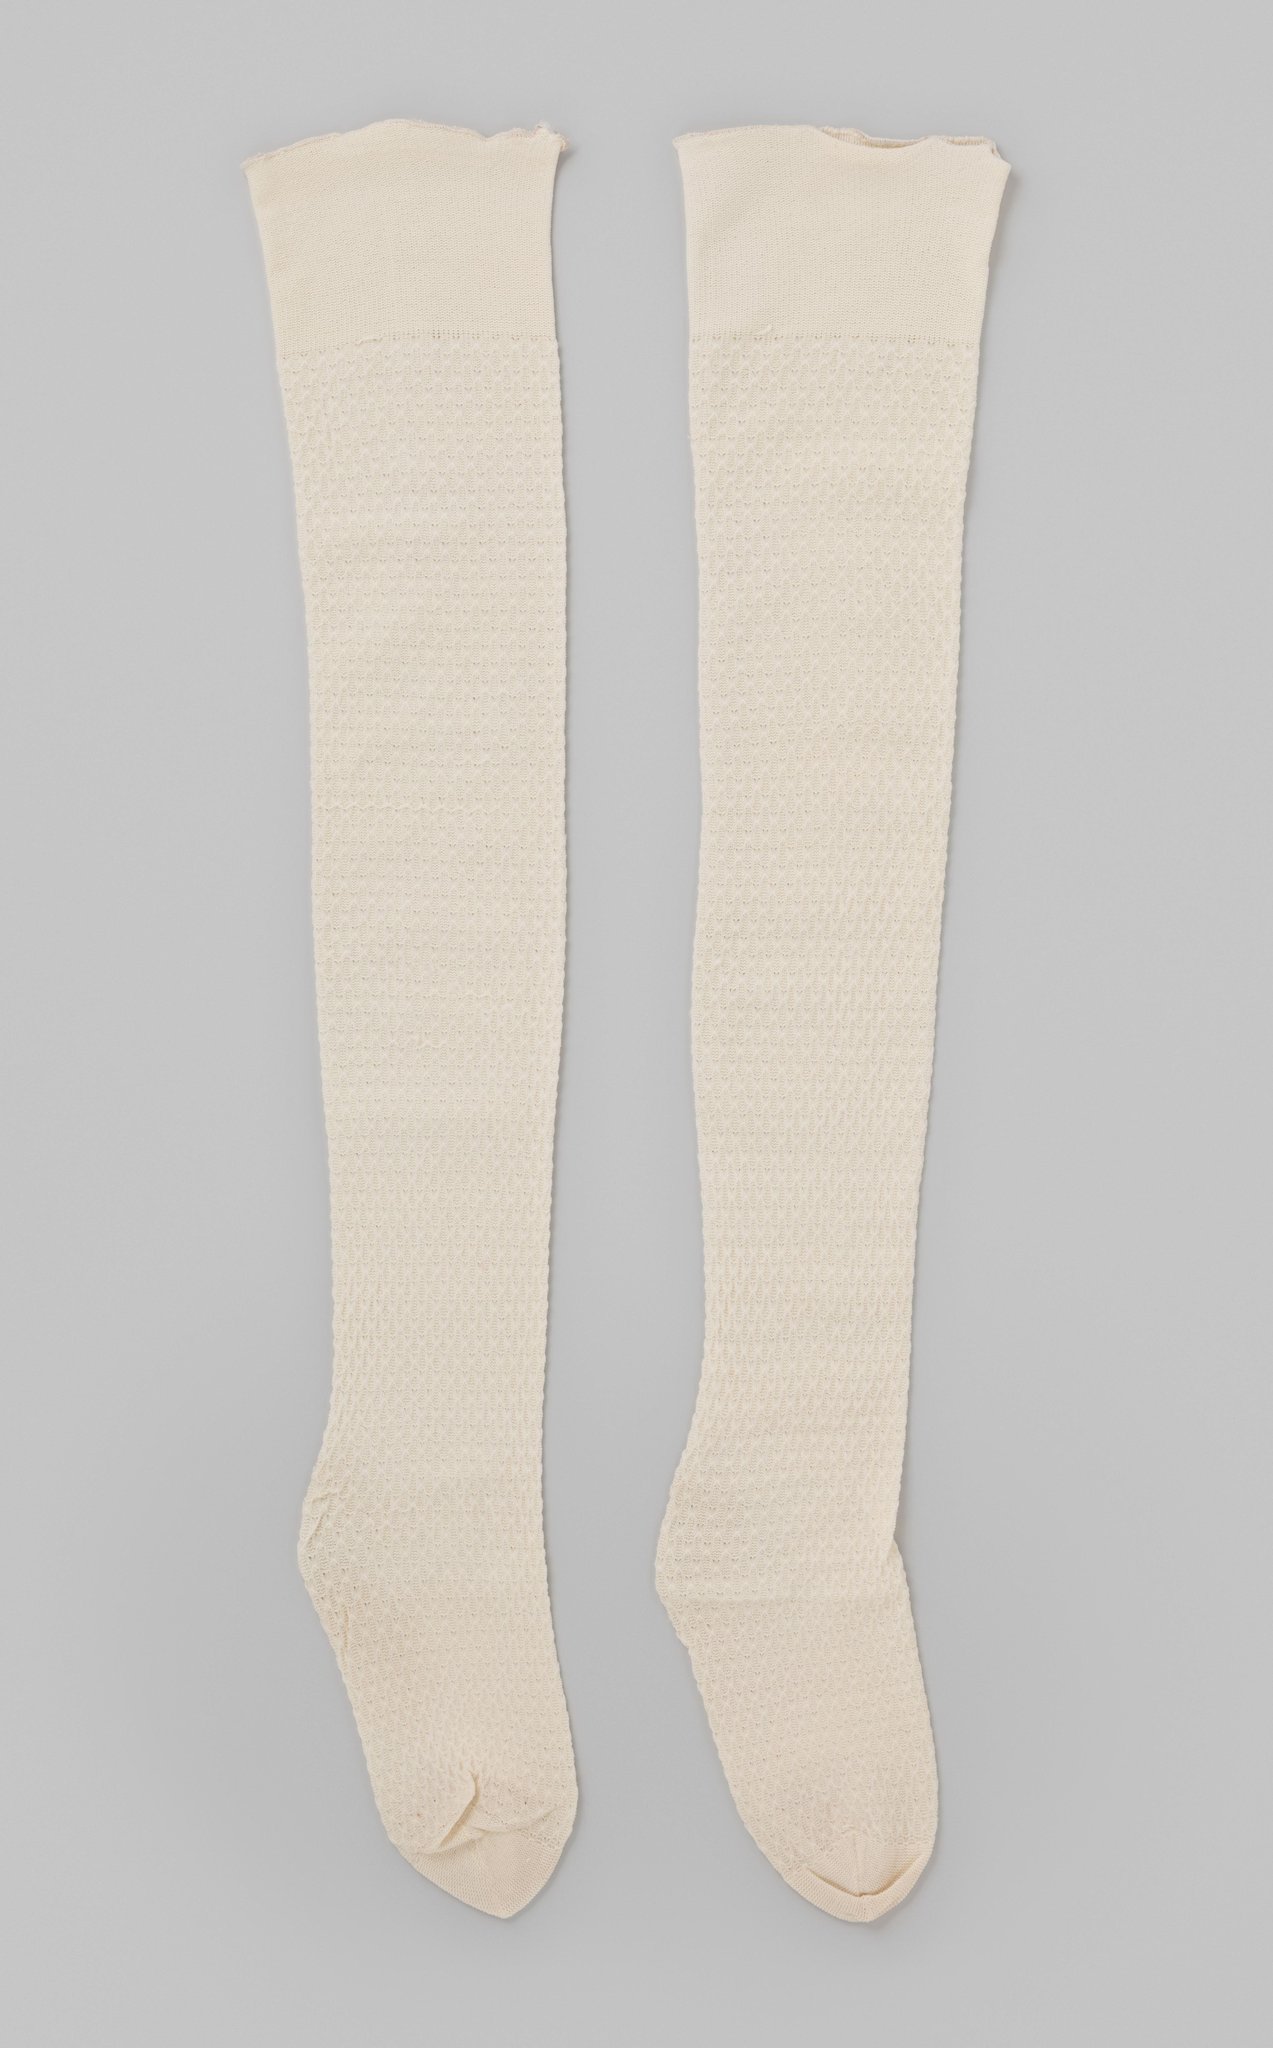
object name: sportkous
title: Kous van witte nylon met ingebreid ster-patroon in reliëf en brede boord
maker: Anonymous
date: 1960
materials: plastic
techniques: knitting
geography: western europe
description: Sportkous van witte nylon met ingebreid ster-patroon in reliëf. Naadloos, enkelvoudige boord met rolelastiek.